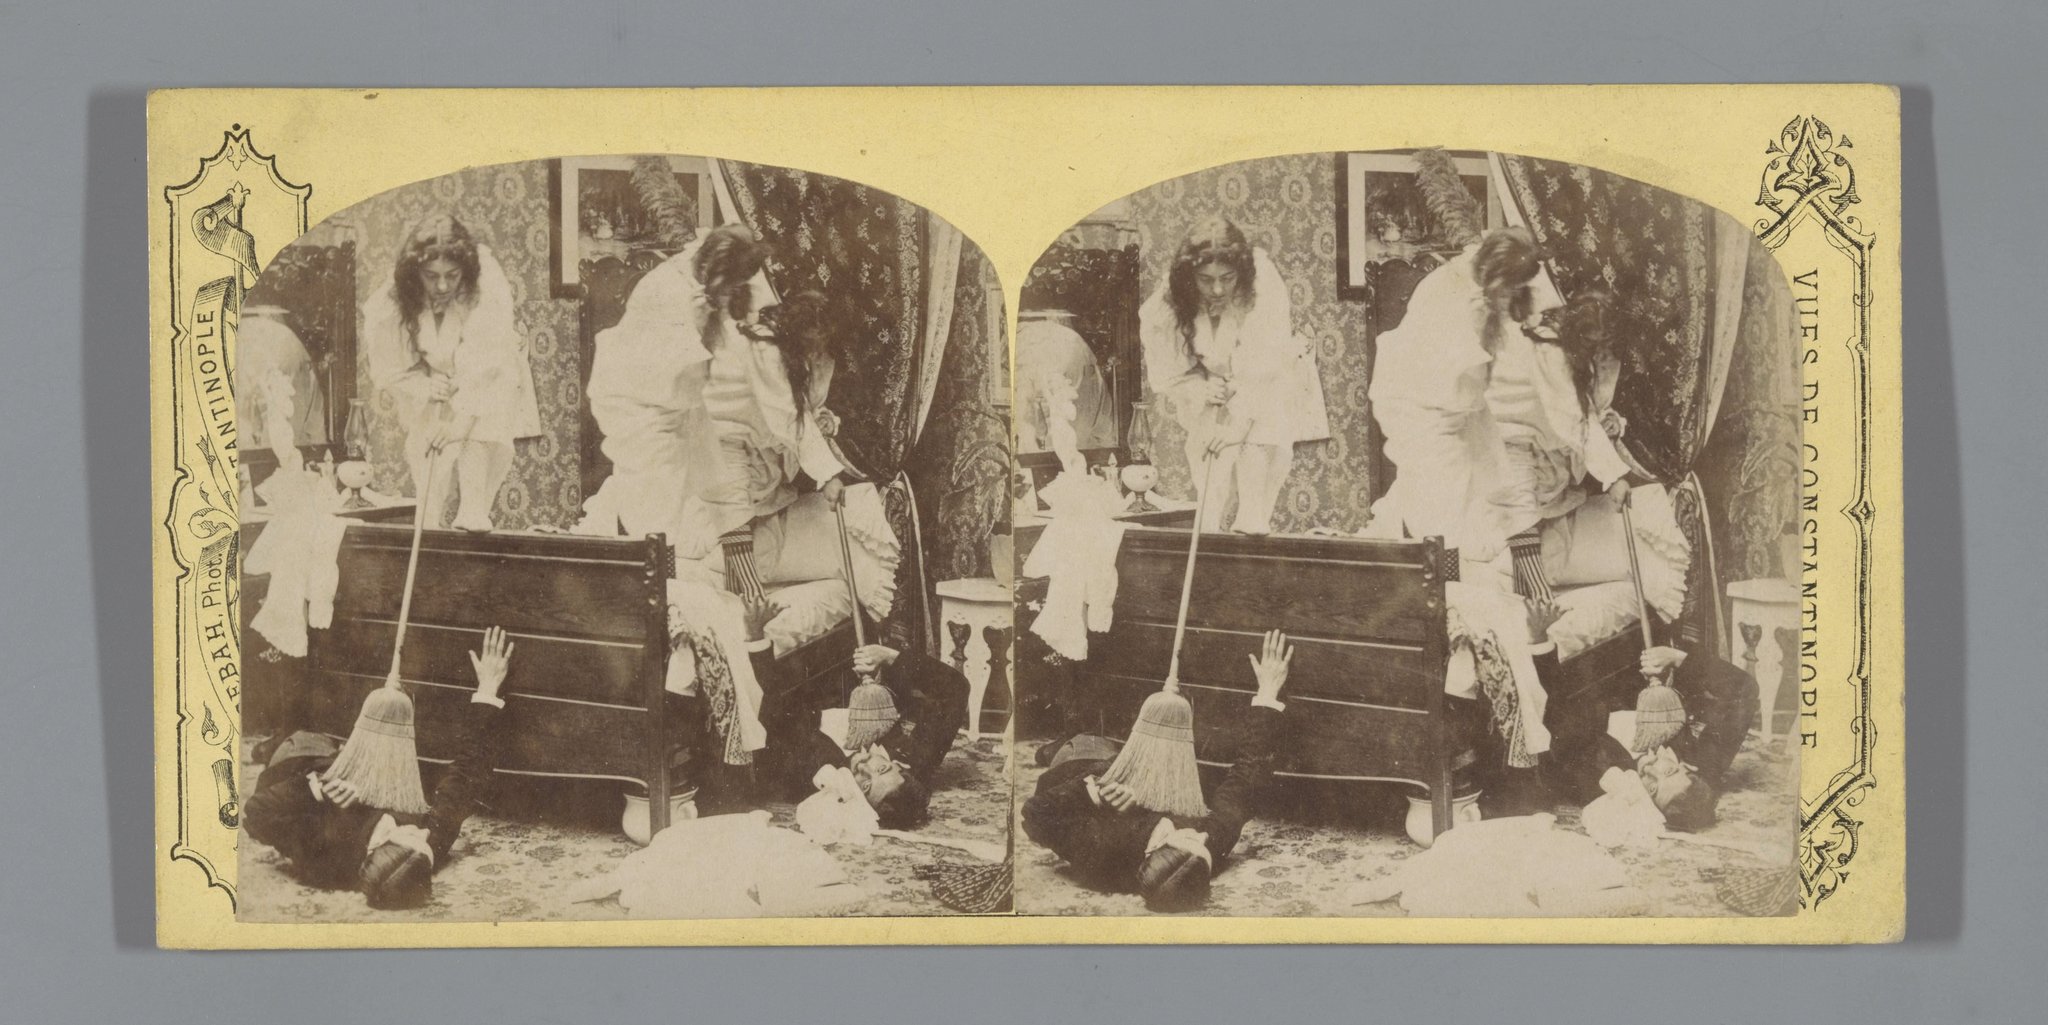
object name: stereograph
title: Drie jonge vrouwen in nachtkleding jagen mannen met bezems onder bed vandaan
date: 1890-1900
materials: cardboard, photographic support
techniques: albumen print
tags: underclothes, bed, shrubs: broom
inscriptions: : ‘Vues de Constantinople’